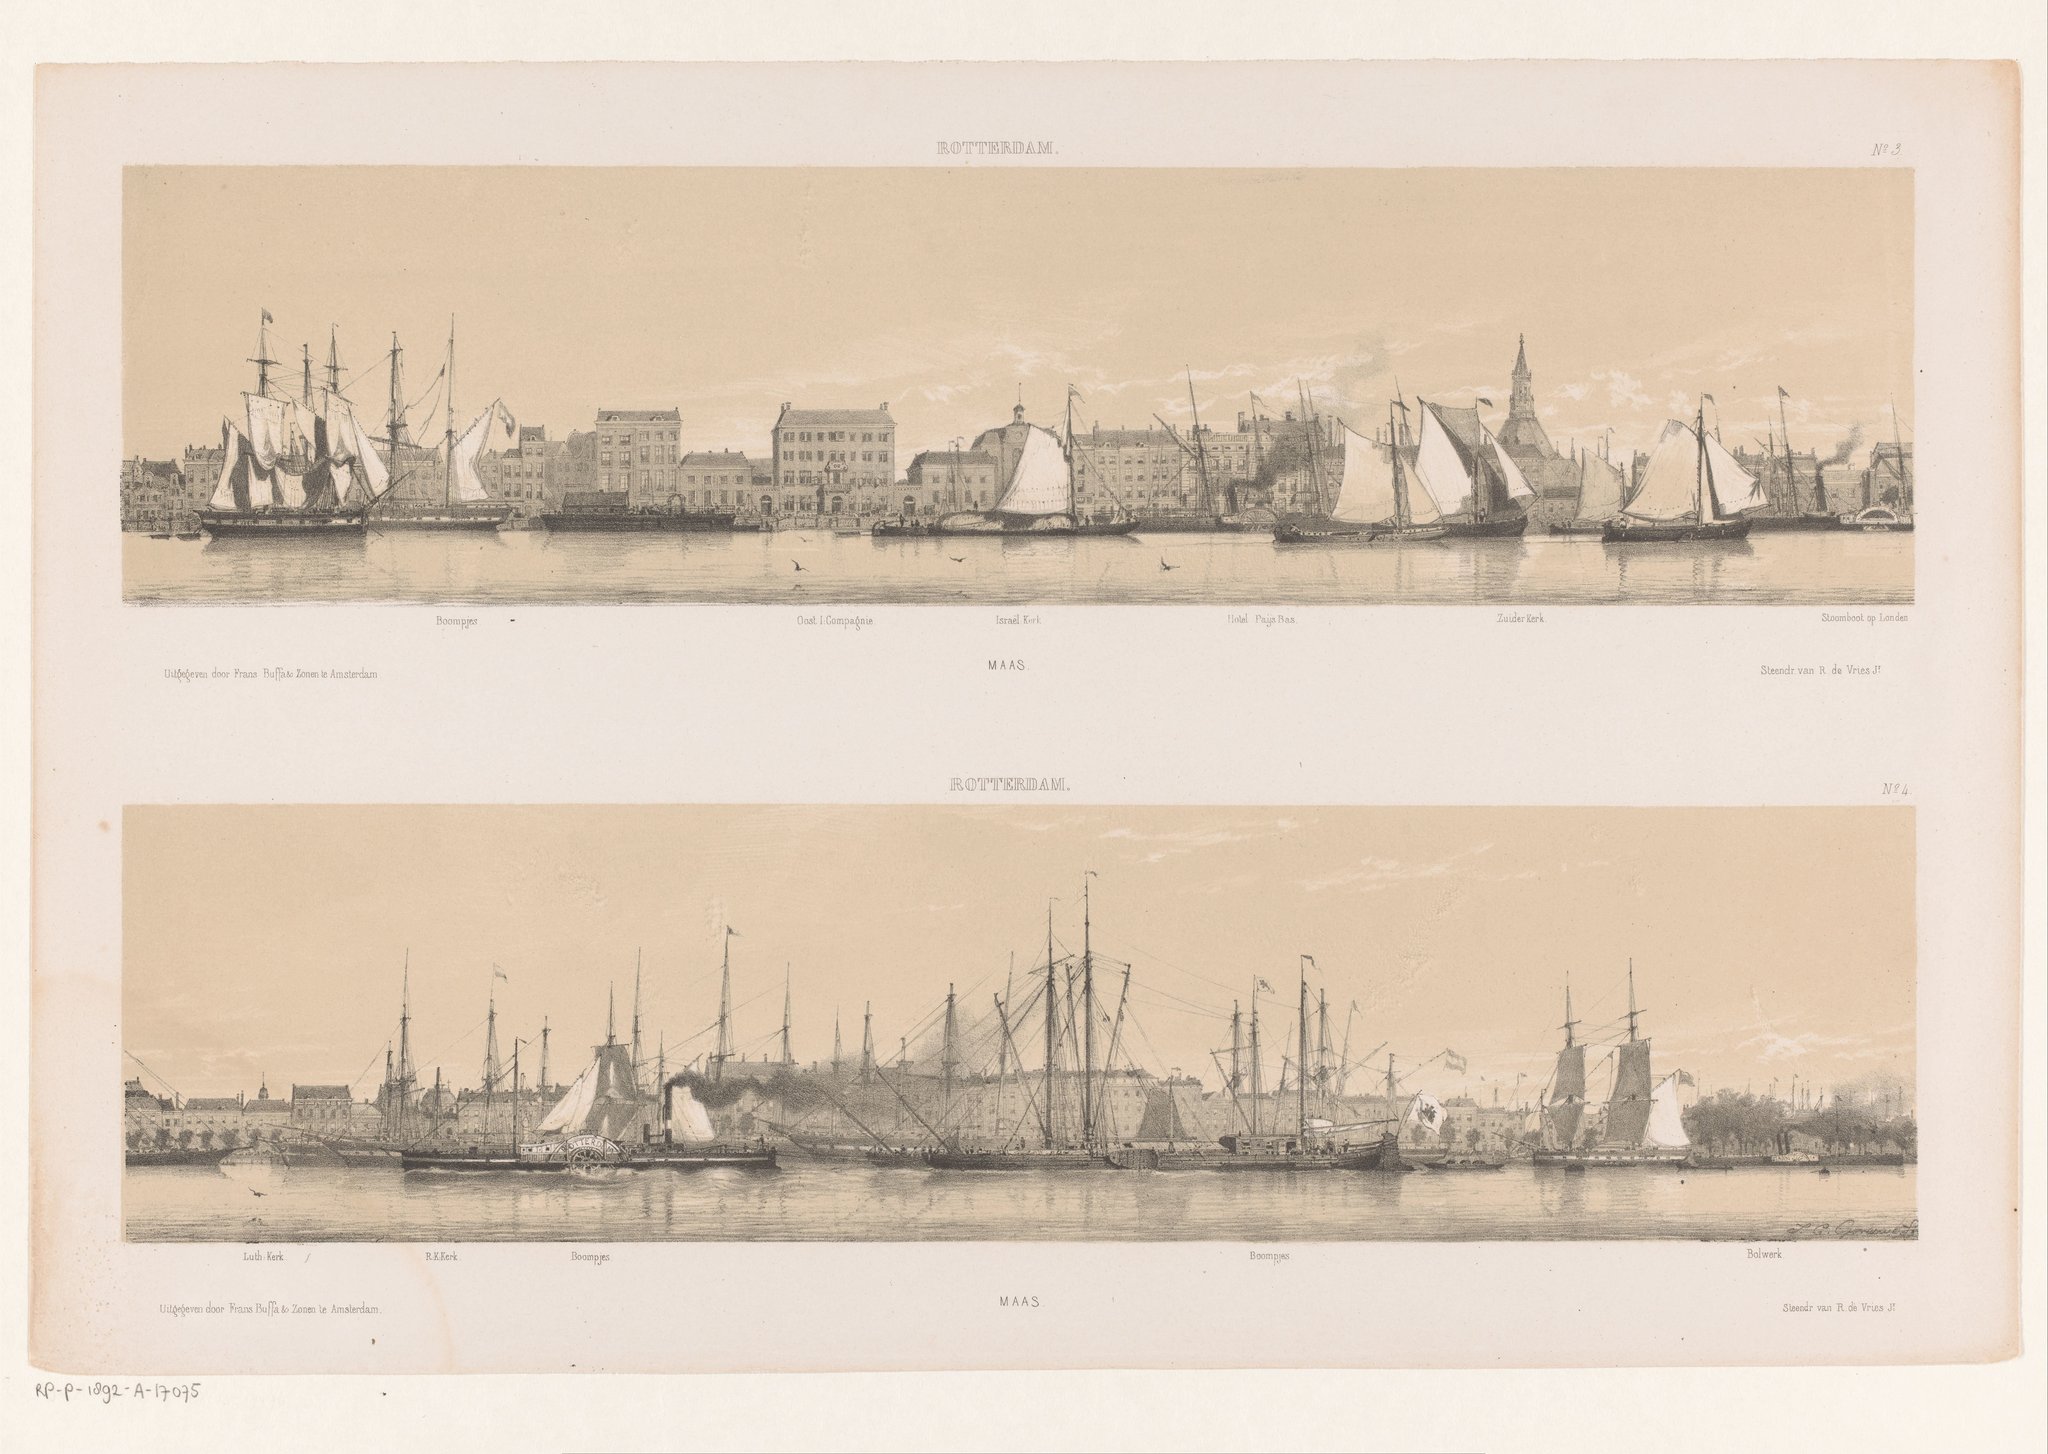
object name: print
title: Profiel van Rotterdam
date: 1860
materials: paper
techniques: tone lithography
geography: amsterdam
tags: prospect of city, town panorama, silhouette of city, rotterdam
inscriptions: collector's mark: Lugt 2228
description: De stad is vanaf de Maas gezien. In het bovenste profiel zijn de Boompjes, de Oost-Indische Compagnie, de Israël Kerk, Hotel Pays Bas, de Zuiderkerk en de Stoomboot op Londen afgebeeld. Het tweede profiel daaronder gaat door met de Lutherse Kerk, de Rooms Katholieke Kerk, de Boompjes en het Bolwerk. Beiden profielen zijn rechtsboven genummerd.